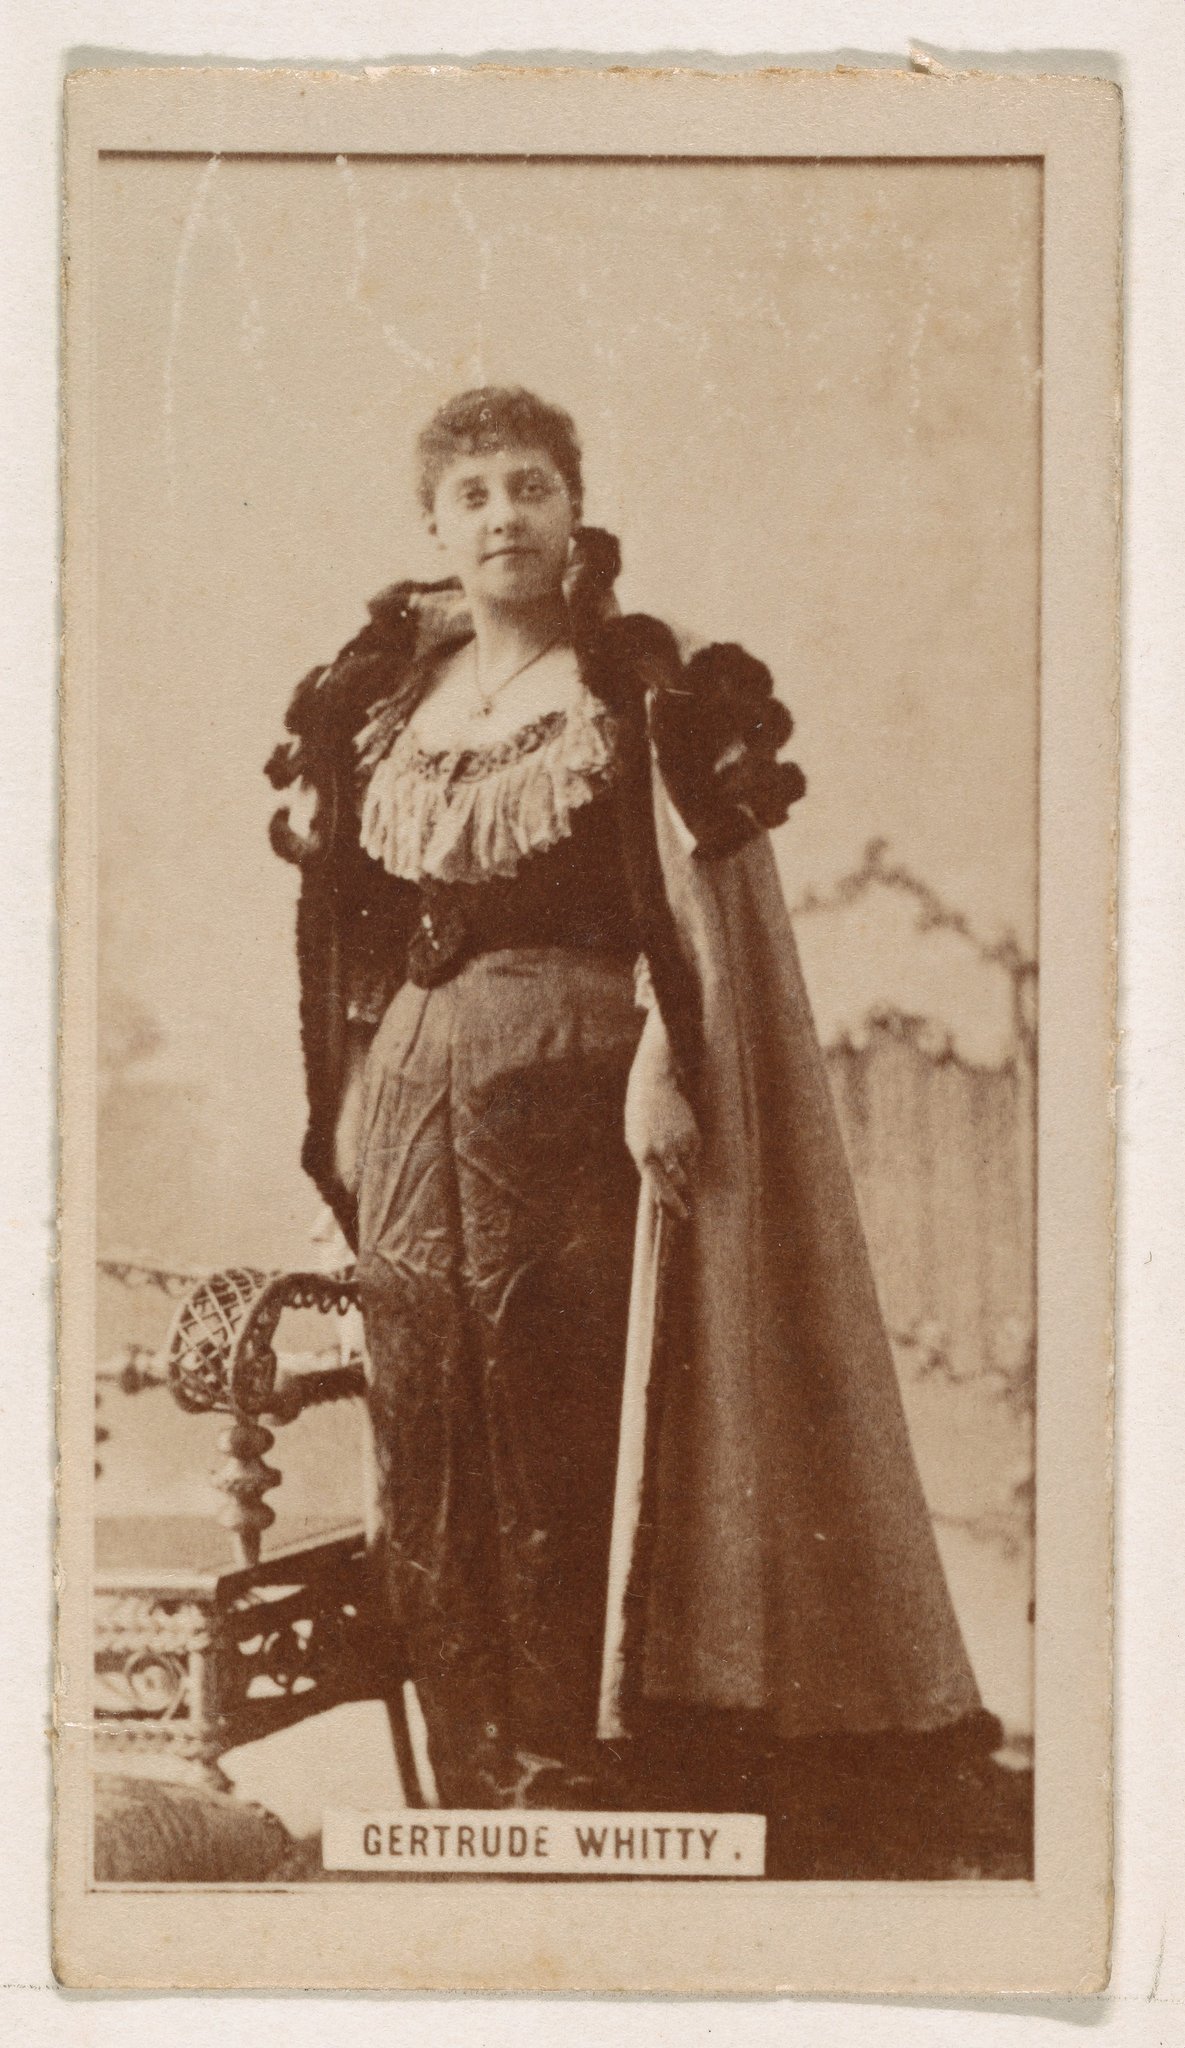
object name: photograph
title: Gertrude Whitty, from the Actresses series (N245) issued by Kinney Brothers to promote Sweet Caporal Cigarettes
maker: kinney brothers tobacco company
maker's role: publisher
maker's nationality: american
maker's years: 1869-2011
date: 1890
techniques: albumen silver print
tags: portraits,women,actresses